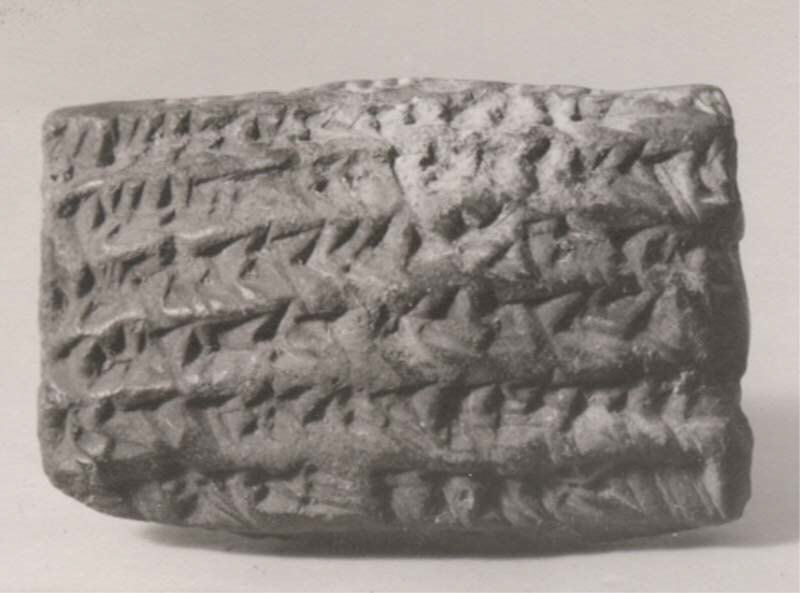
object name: cuneiform tablet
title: Cuneiform tablet: declaration before witnesses, archive of Iddin-Nabu and Shellebi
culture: achaemenid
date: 516 BCE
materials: clay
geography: mesopotamia